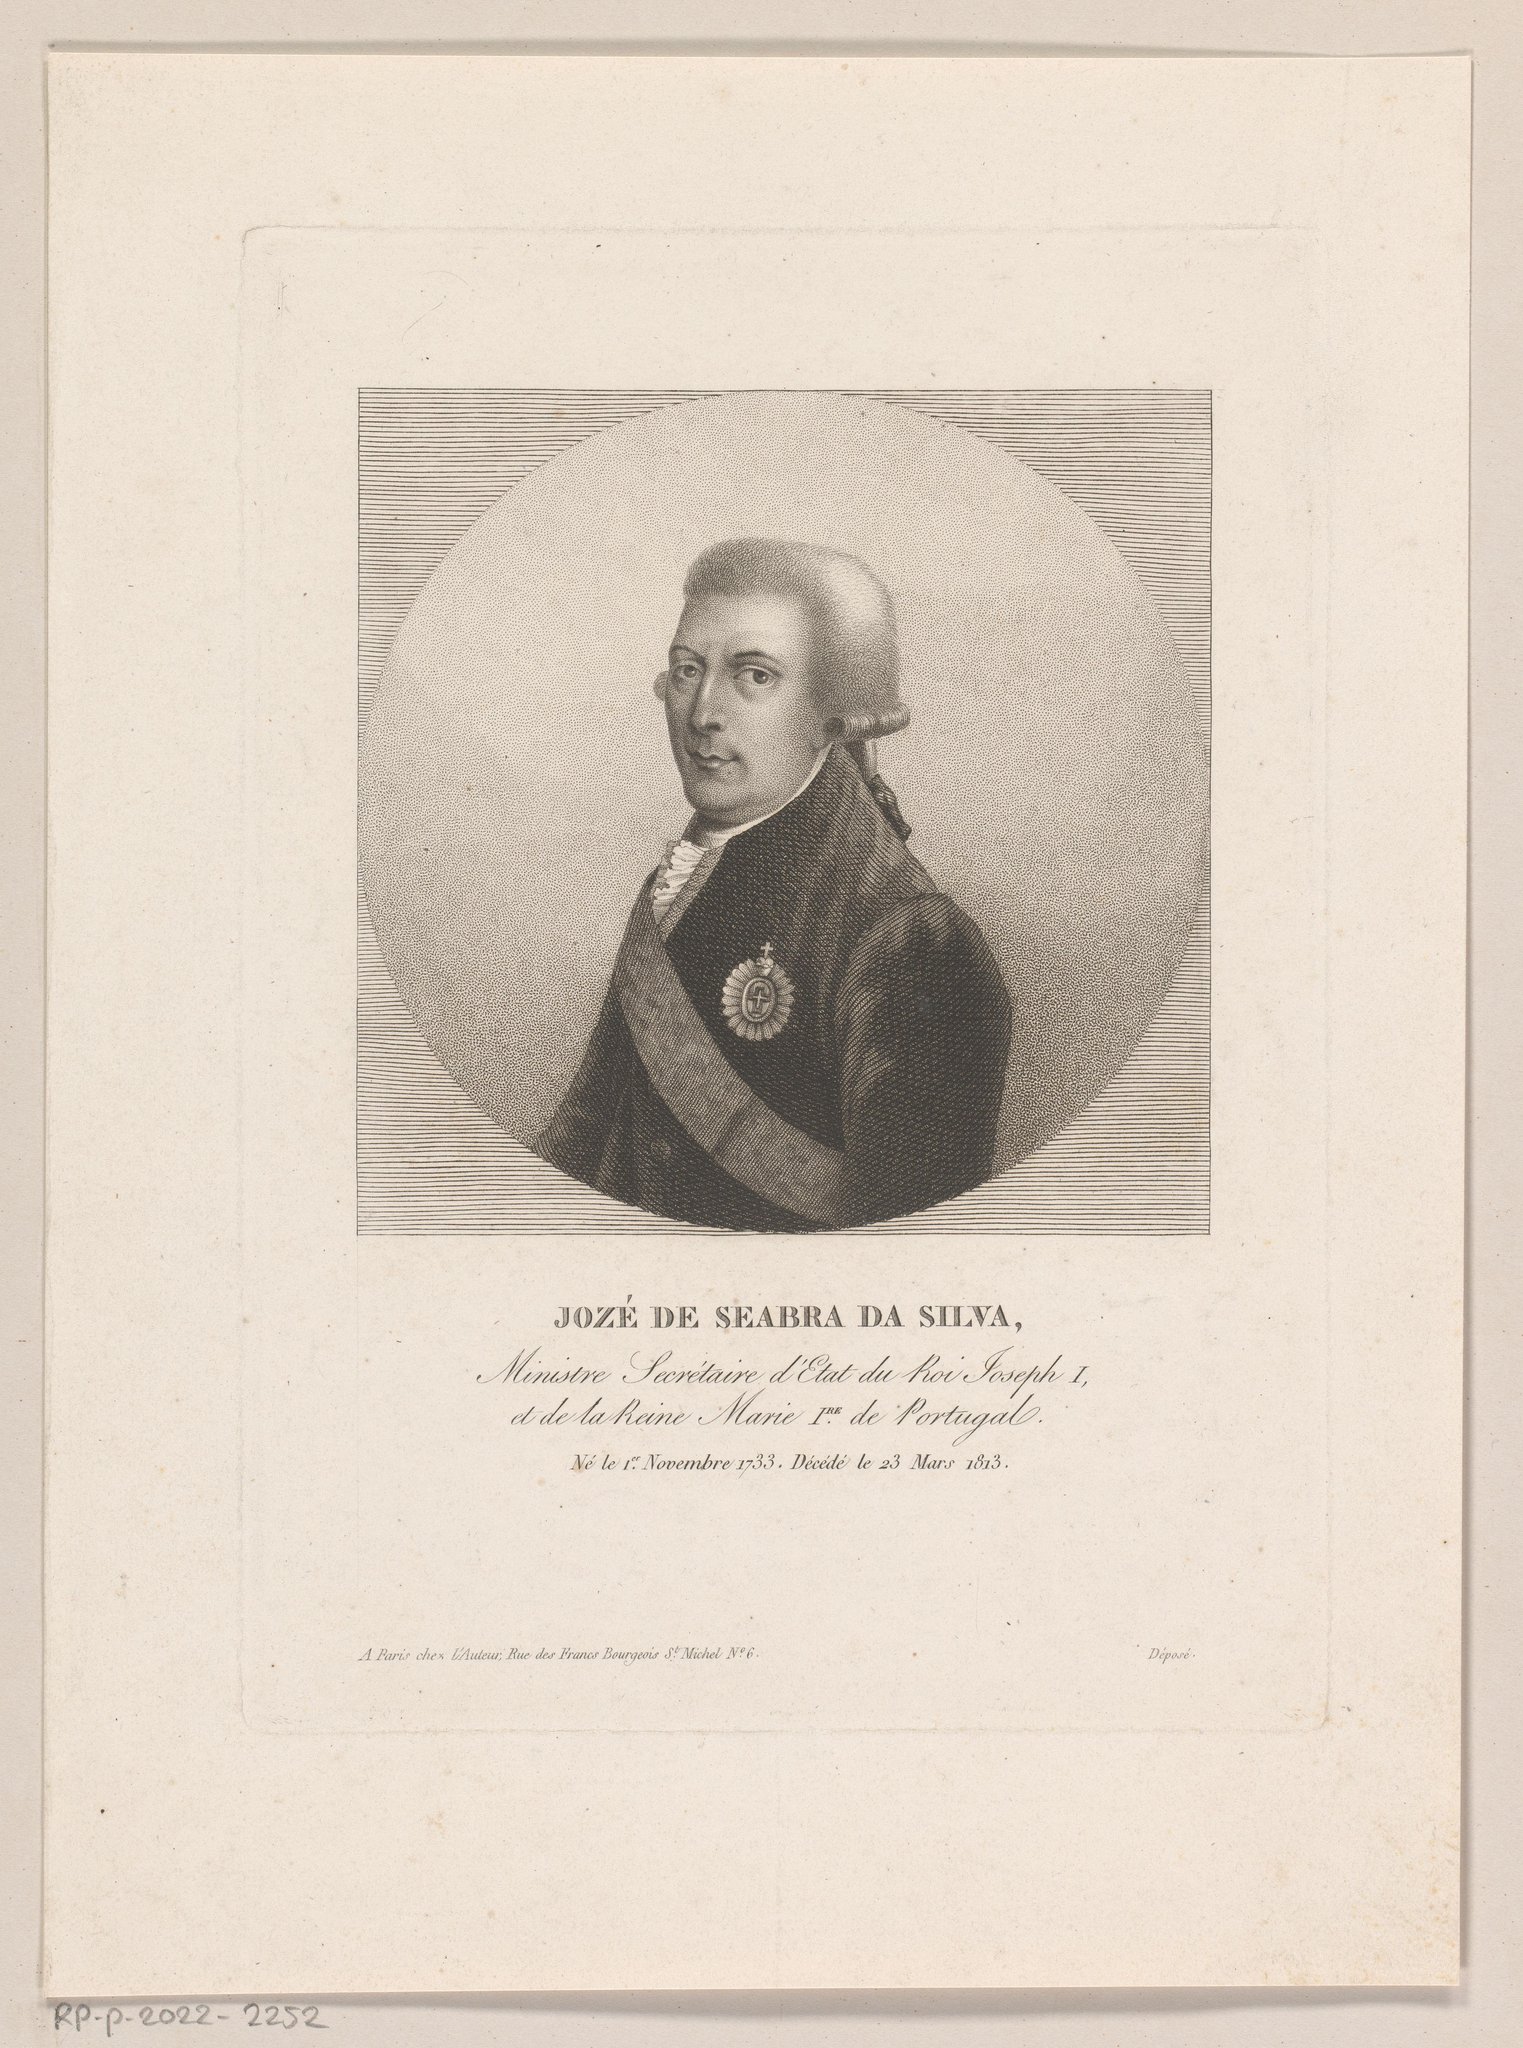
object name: print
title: Portret van José de Seabra da Silva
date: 1813-1899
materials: paper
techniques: engraving, etching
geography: paris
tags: historical persons, politician, e.g. party leader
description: Met drieregelig onderschrift in het Frans.